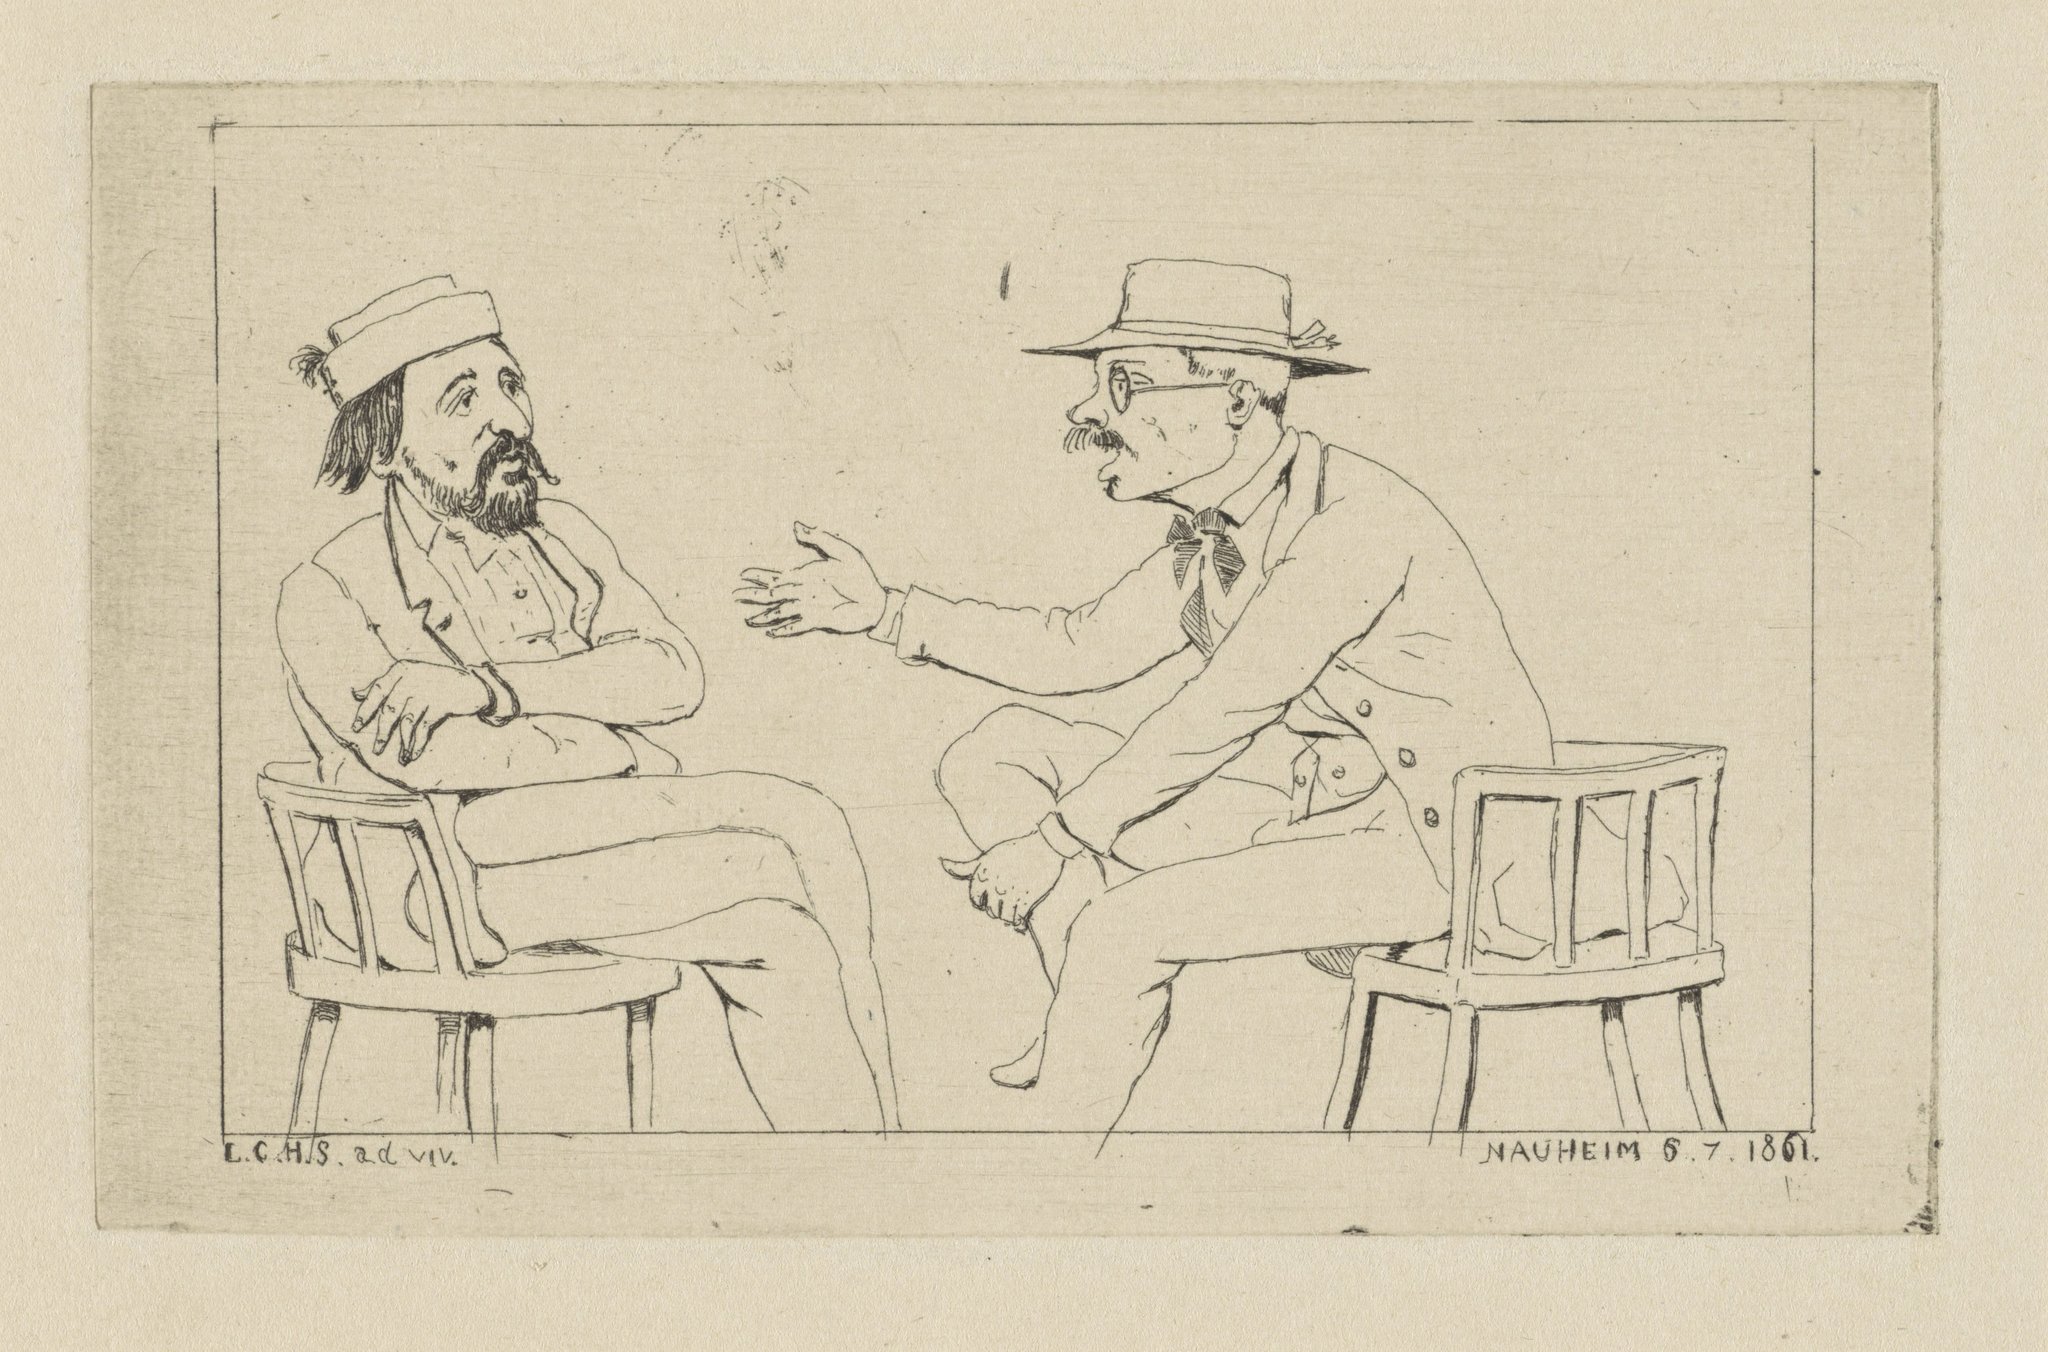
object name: print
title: Twee zittende mannen in gesprek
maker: louis charles hora siccama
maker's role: draughtsman, print maker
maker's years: 1807-1880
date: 1861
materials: paper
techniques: etching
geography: utrecht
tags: debate, discussion (~ meeting)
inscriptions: date